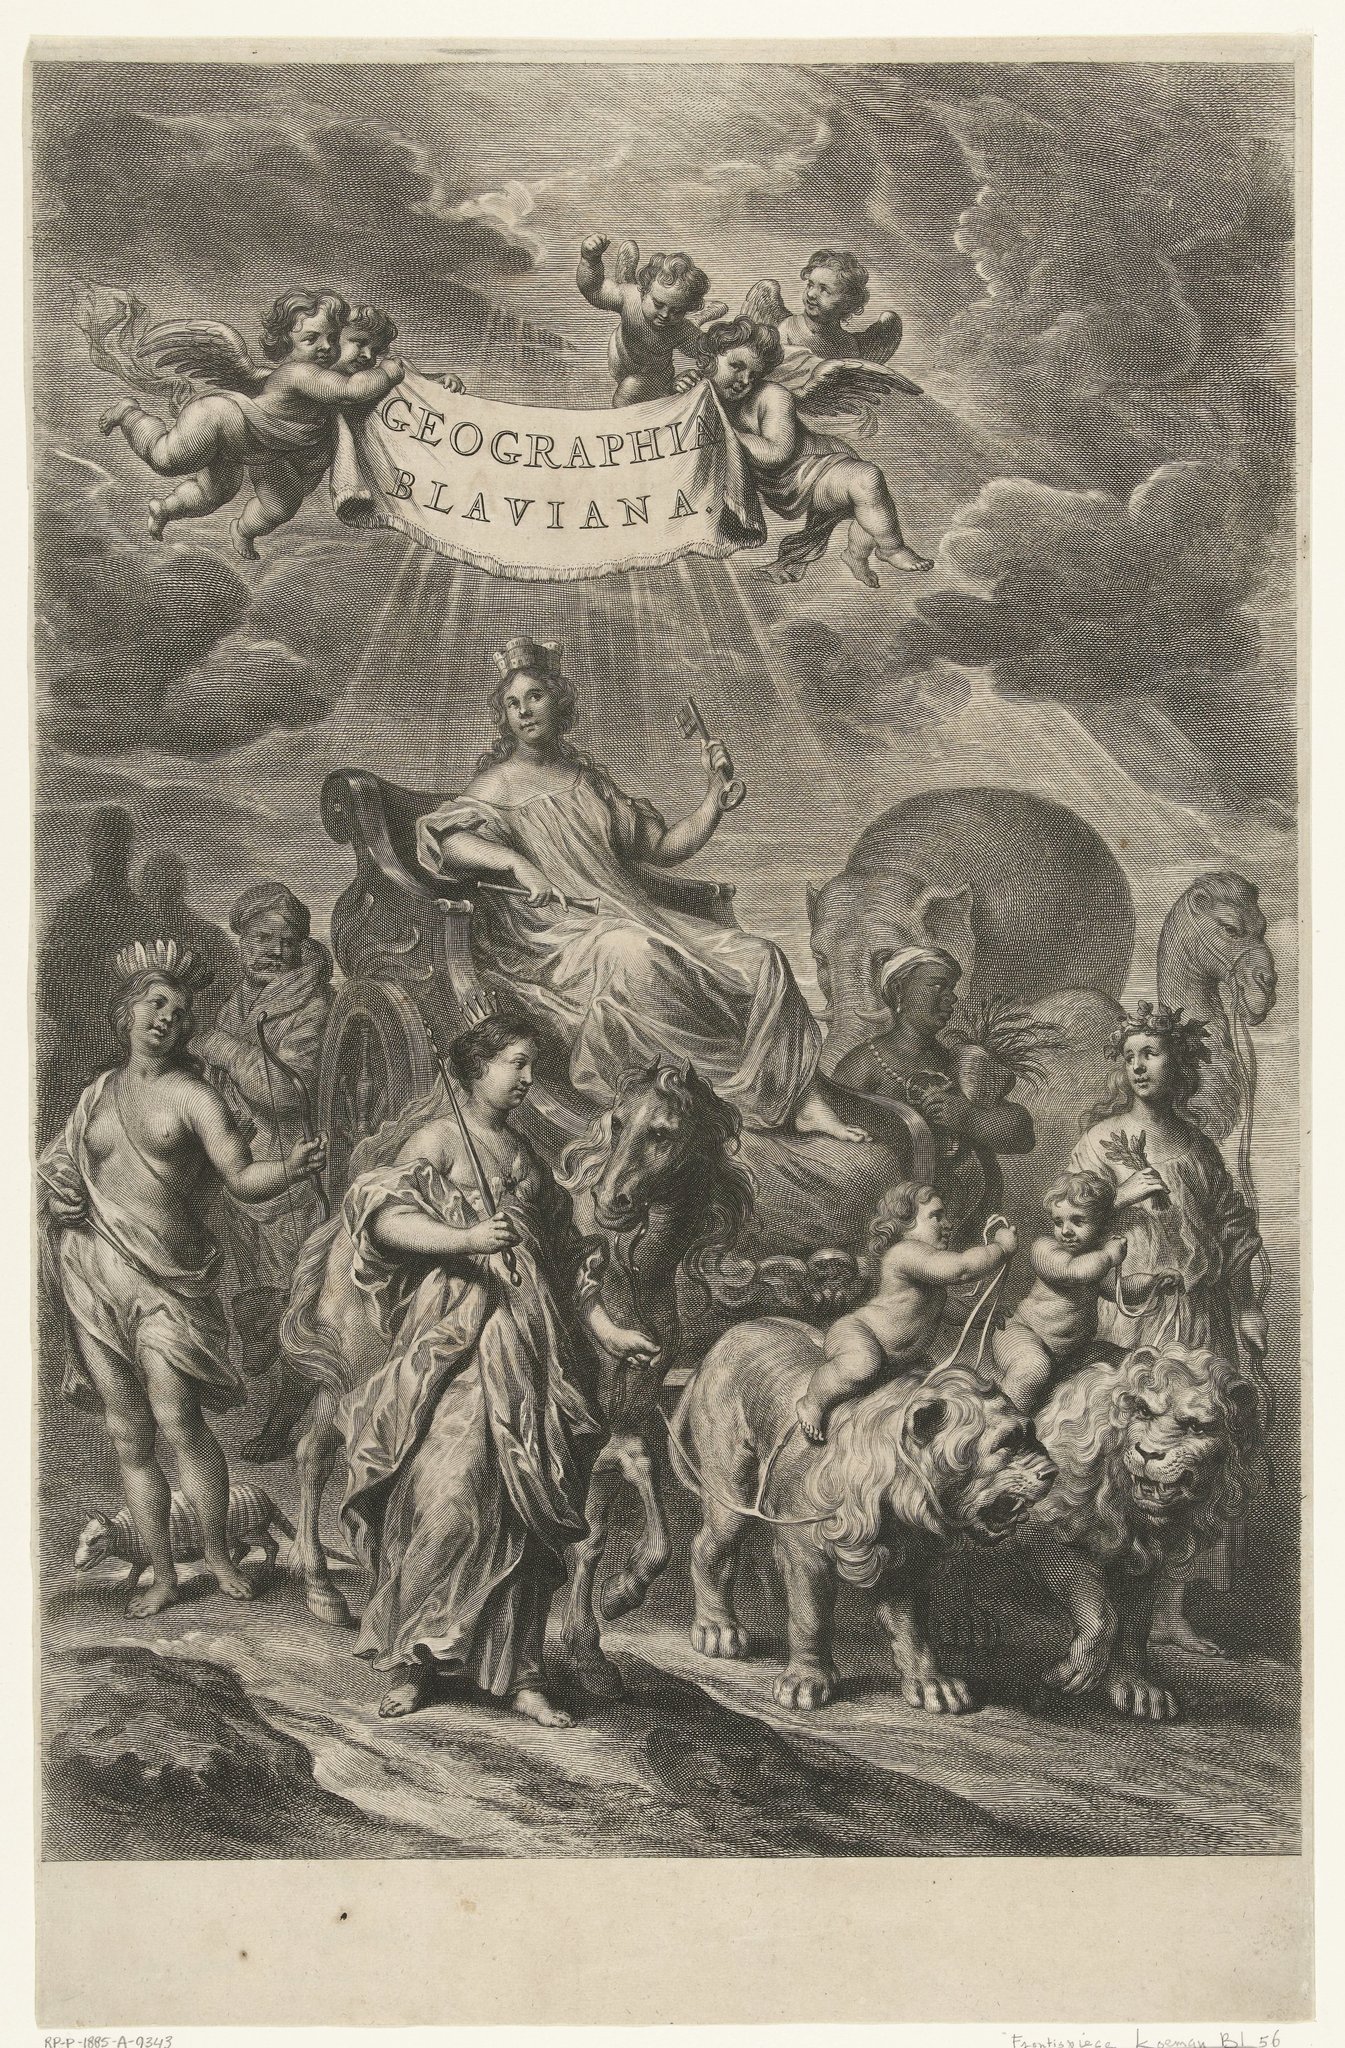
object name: print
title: Geographia Blaviana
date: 1648-1664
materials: paper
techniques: engraving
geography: amsterdam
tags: 'geografia', europe represented allegorically; 'europa' (ripa), asia represented allegorically; 'asia' (ripa), africa represented allegorically; 'africa' (ripa), america represented allegorically; 'america' (ripa)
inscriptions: collector's mark: Lugt 2228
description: Vrouwelijke personificatie van Geografie op triomfwagen getrokken door leeuwen. Personificaties van de werelddelen Amerika, Afrika, Azië en Europa met hun attributen, zoals dromedaris en olifant, lopen mee. Opmerkelijk is het attribuut van Amerika, bij haar voeten loopt een gordeldier in plaats van de meer gebruikelijke krokodil of kaaiman. Kleine engelen in de lucht houden een doek vast met de titel van de uitgave.